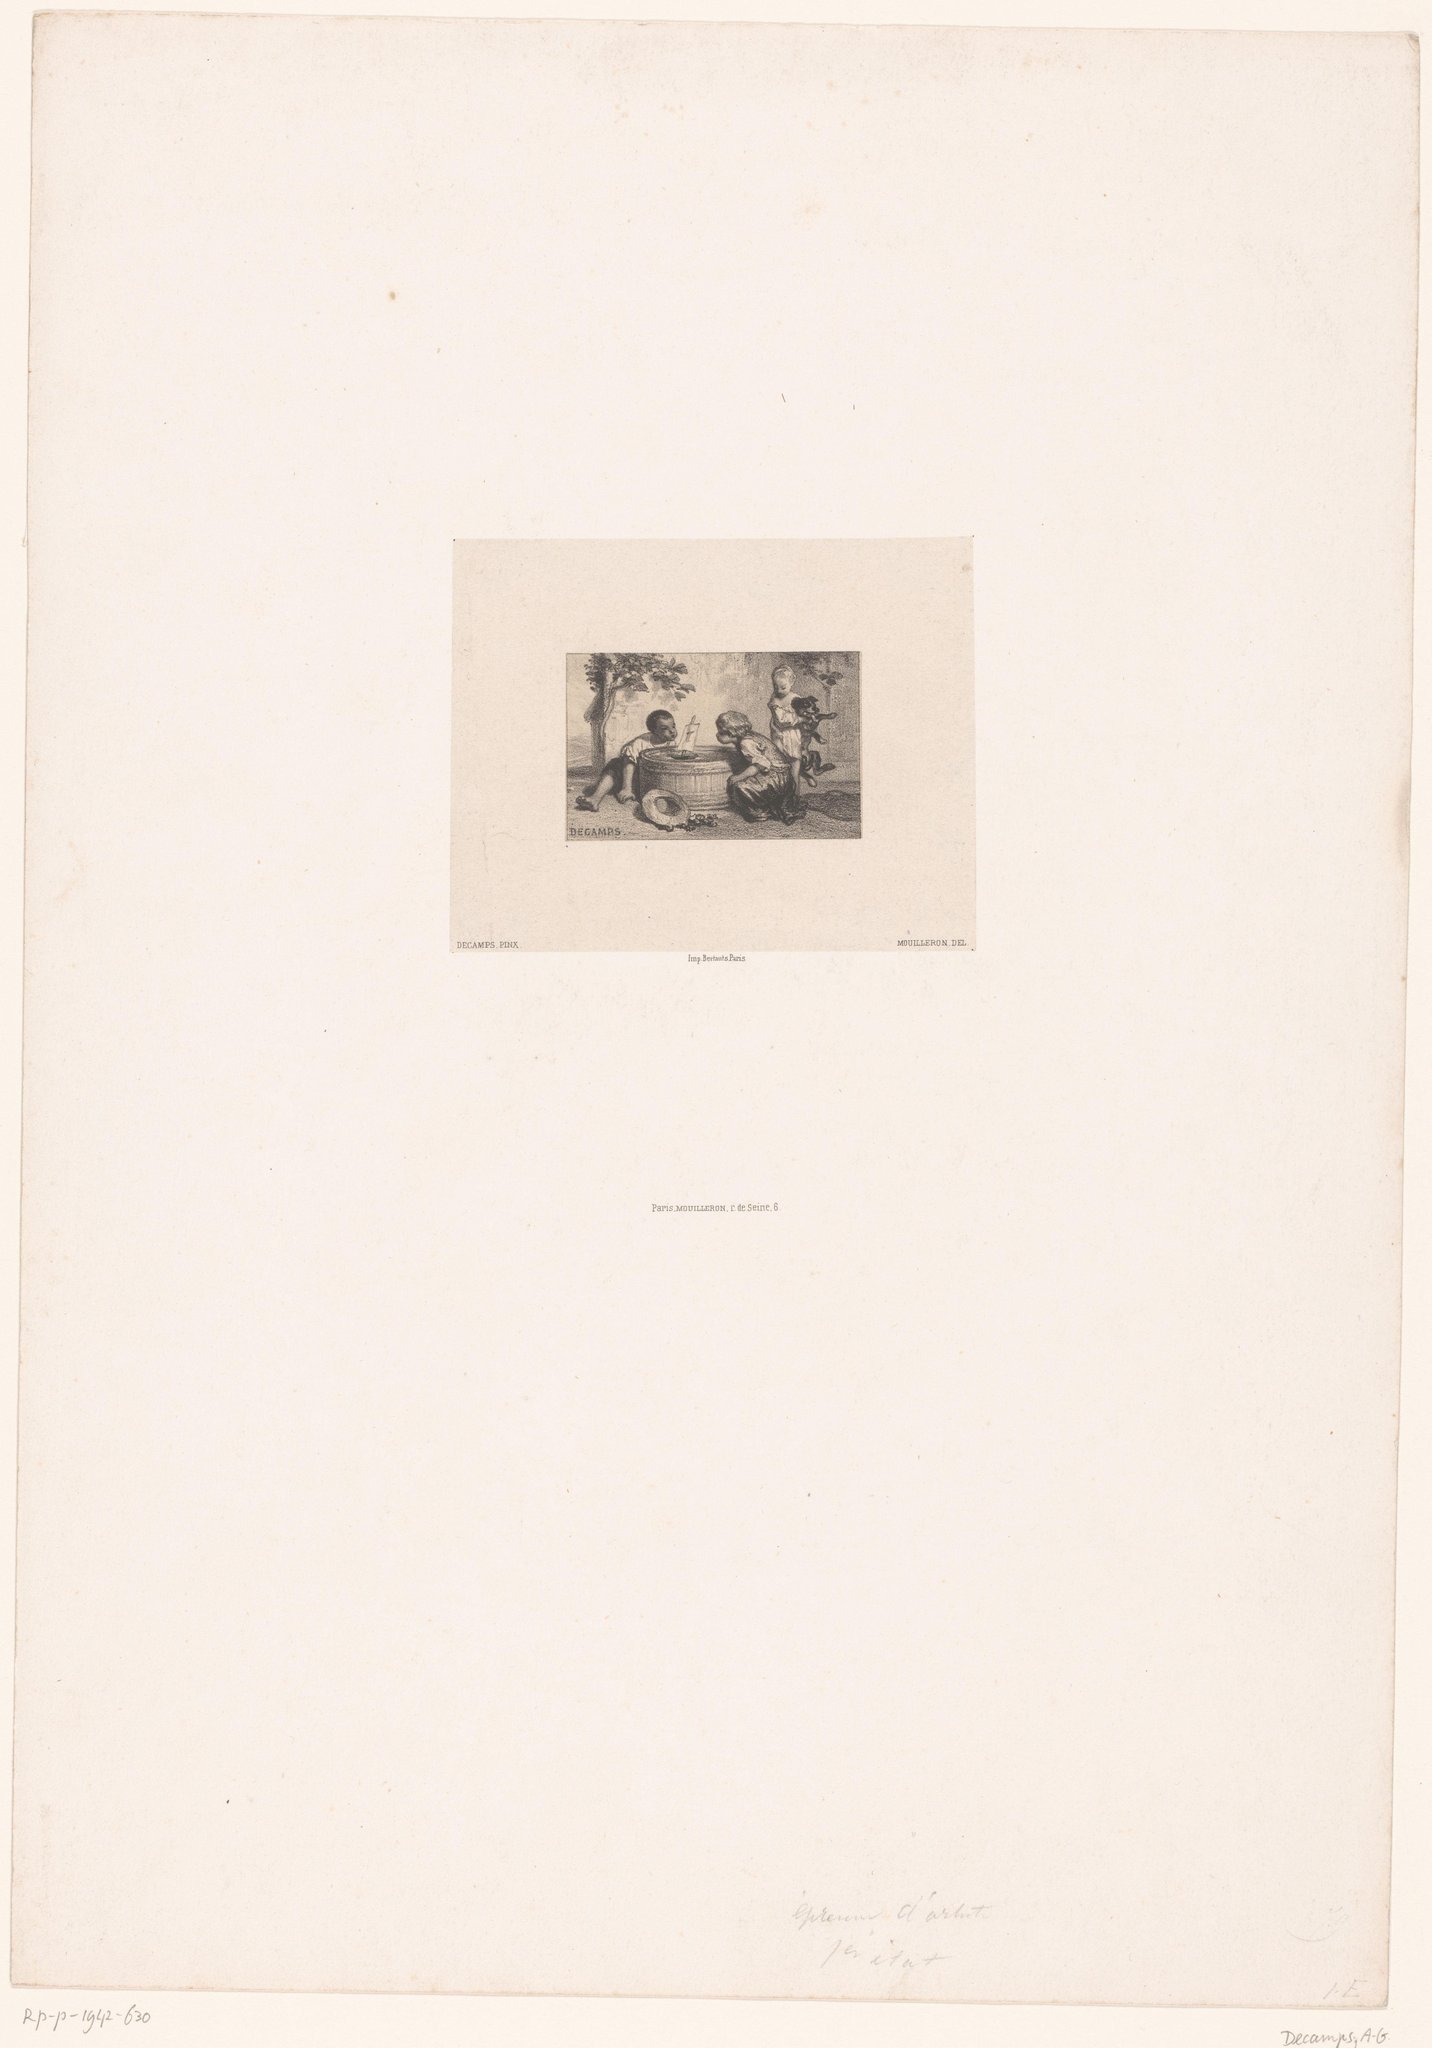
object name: print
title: Kinderen blazen tegen een boot in een teil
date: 1830-1838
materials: paper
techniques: lithograph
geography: paris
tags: child playing with animals, (playing with) toys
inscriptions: collector's mark: Lugt 2228a